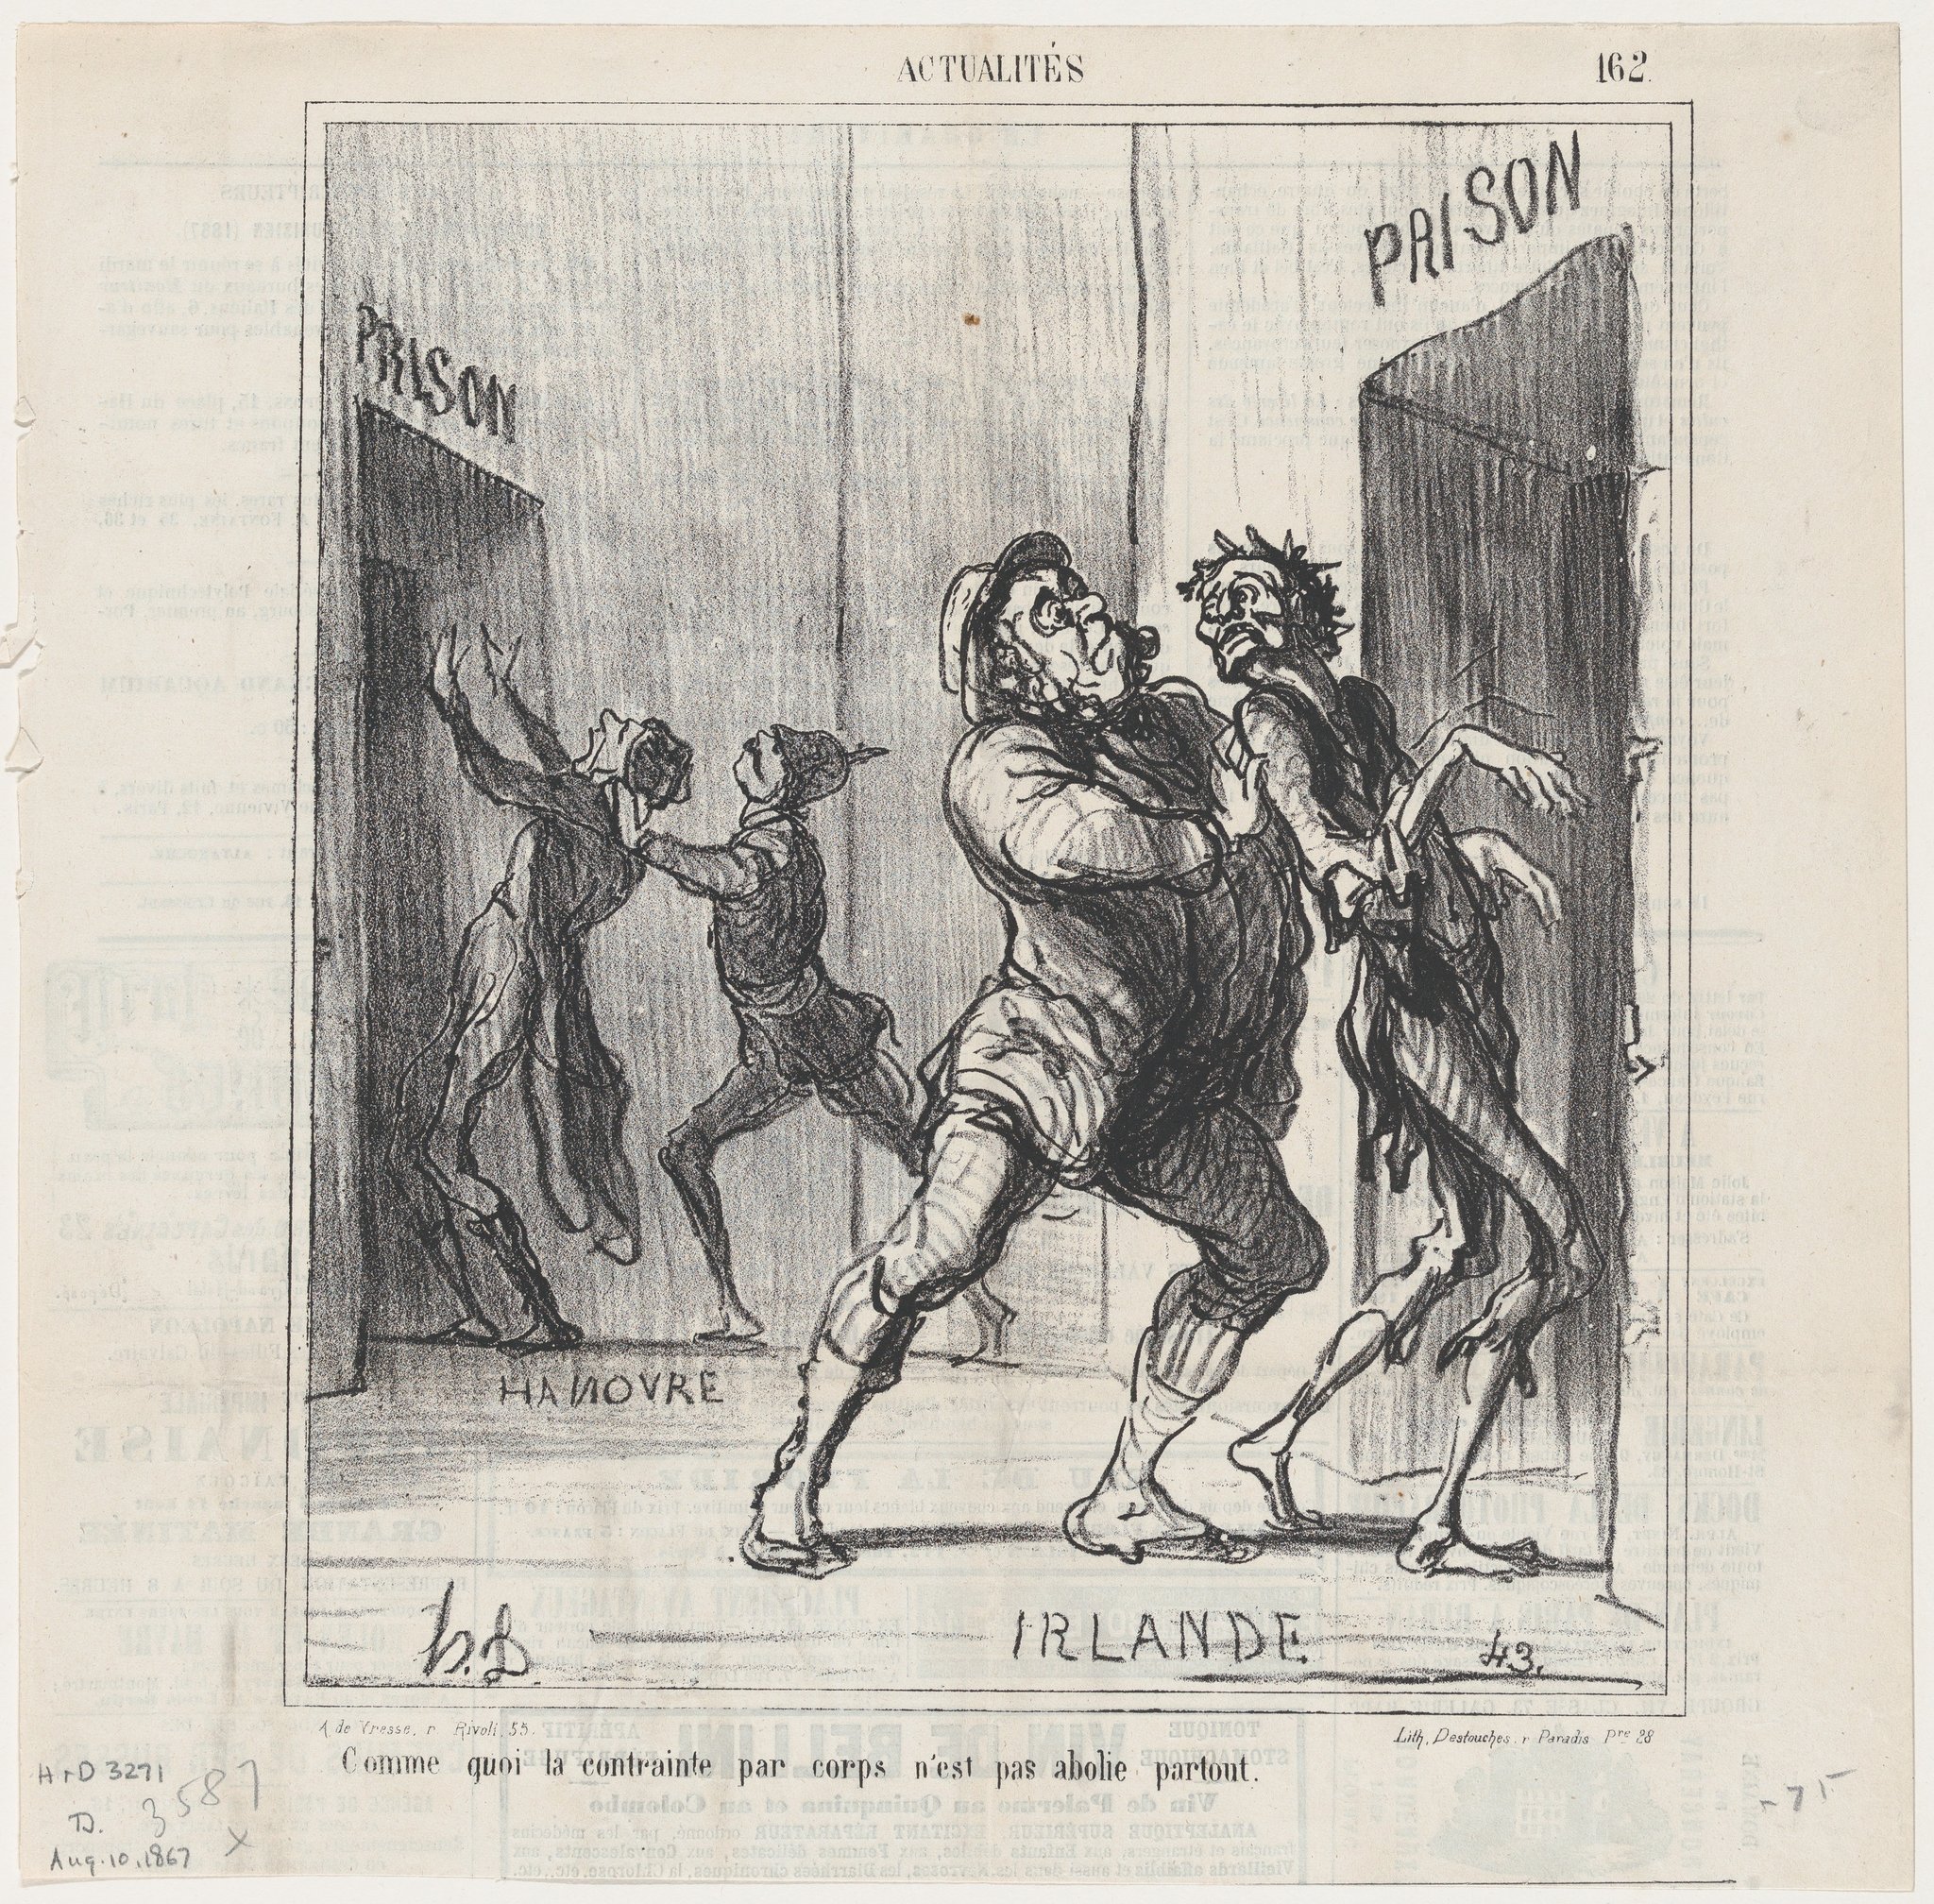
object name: print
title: Which proves that physical imprisonment is not abolished everywhere, from 'News of the day,' published in Le Charivari, August 10, 1867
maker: honoré daumier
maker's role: artist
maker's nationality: french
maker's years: 1808-1879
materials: paper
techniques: lithograph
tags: prisons,men